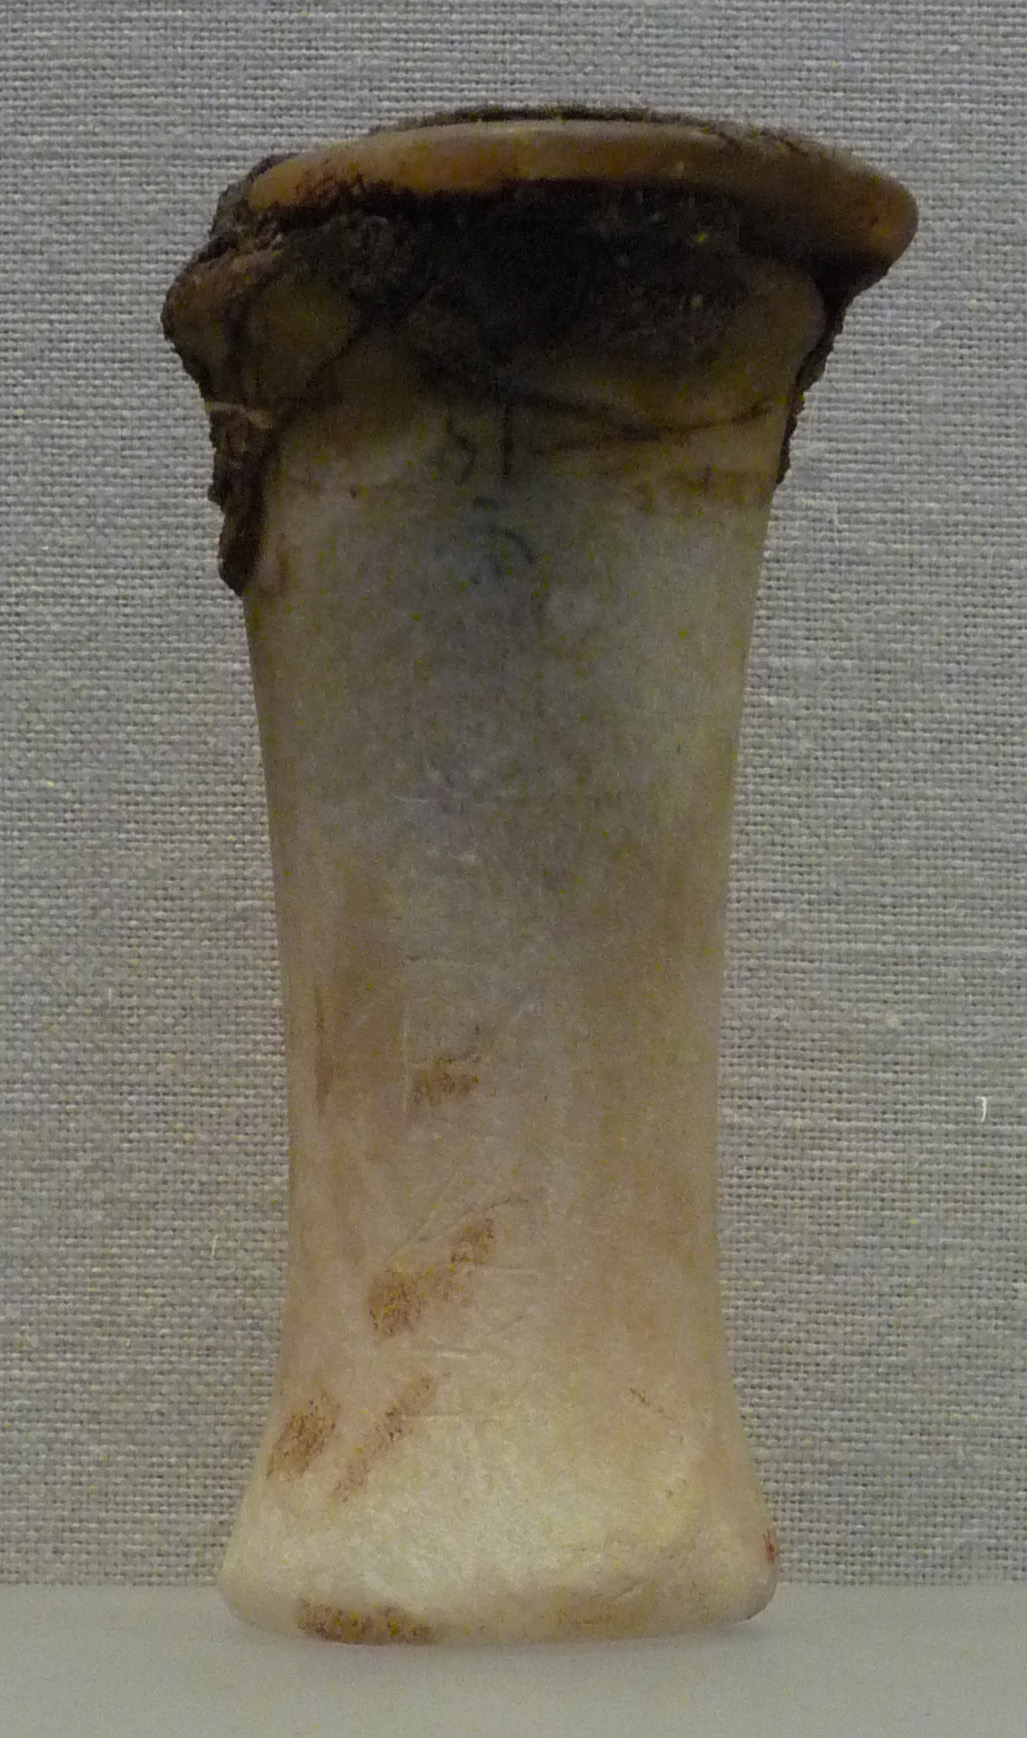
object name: ointment jar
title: Inscribed Ointment Jar From Foundation Deposit 2 of Hatshepsut's Valley Temple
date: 1479-1458 BCE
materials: linen, stone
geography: egypt